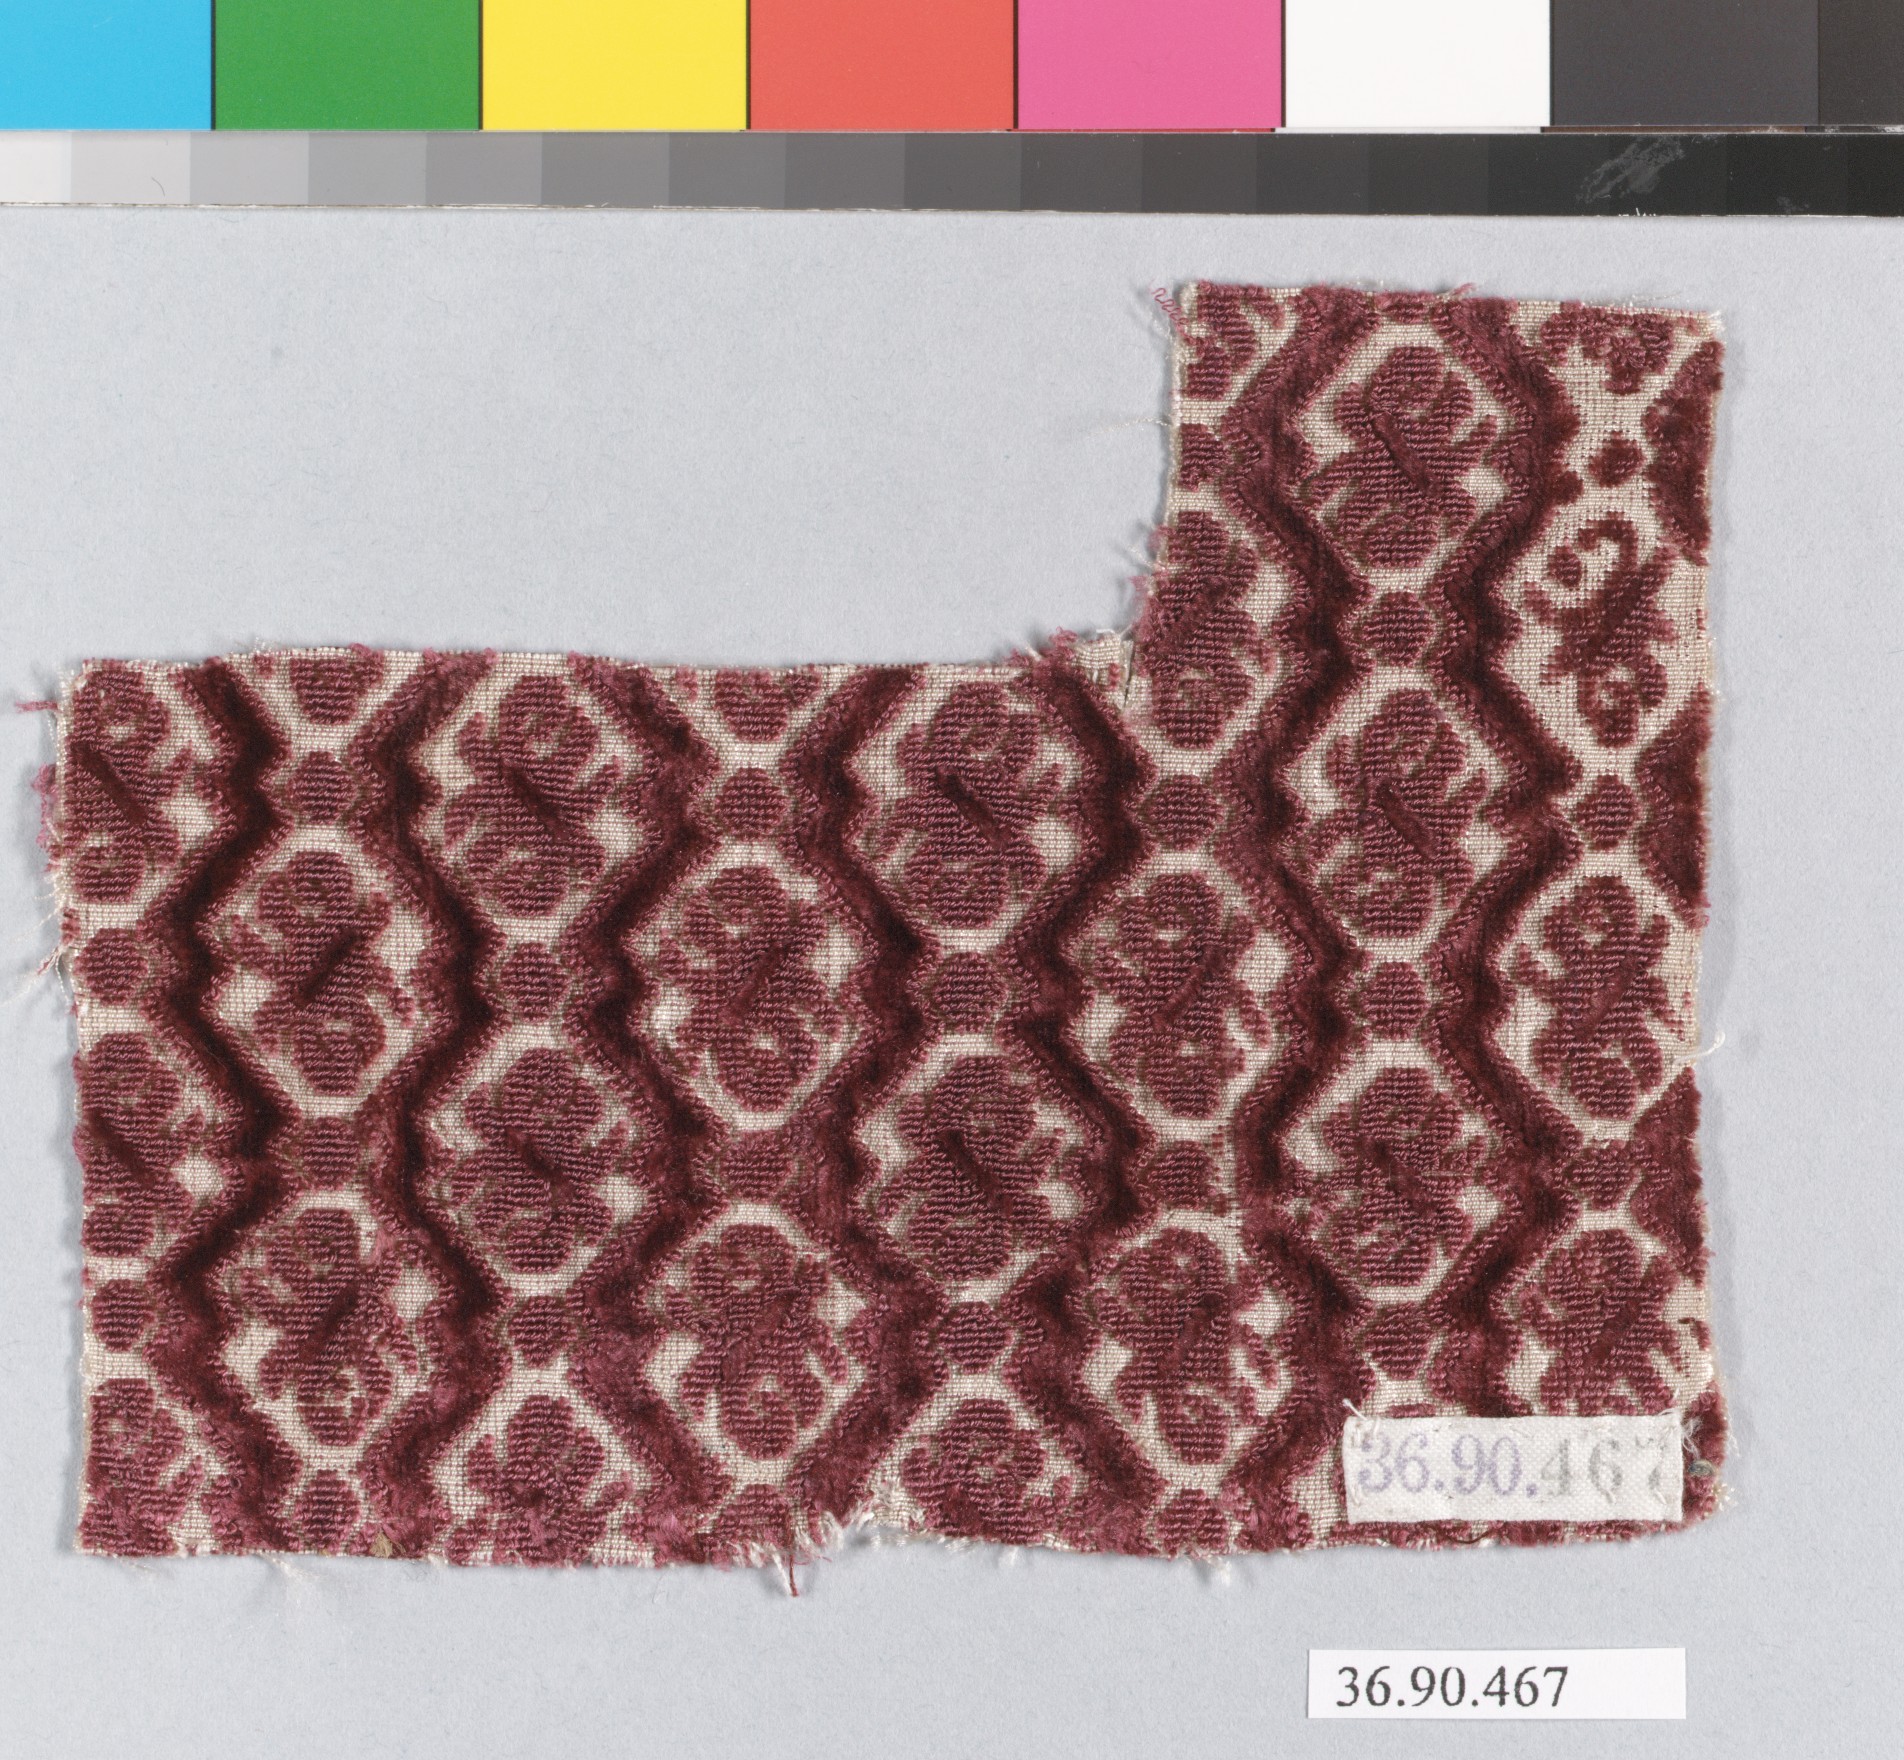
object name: piece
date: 1501-1700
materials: silk